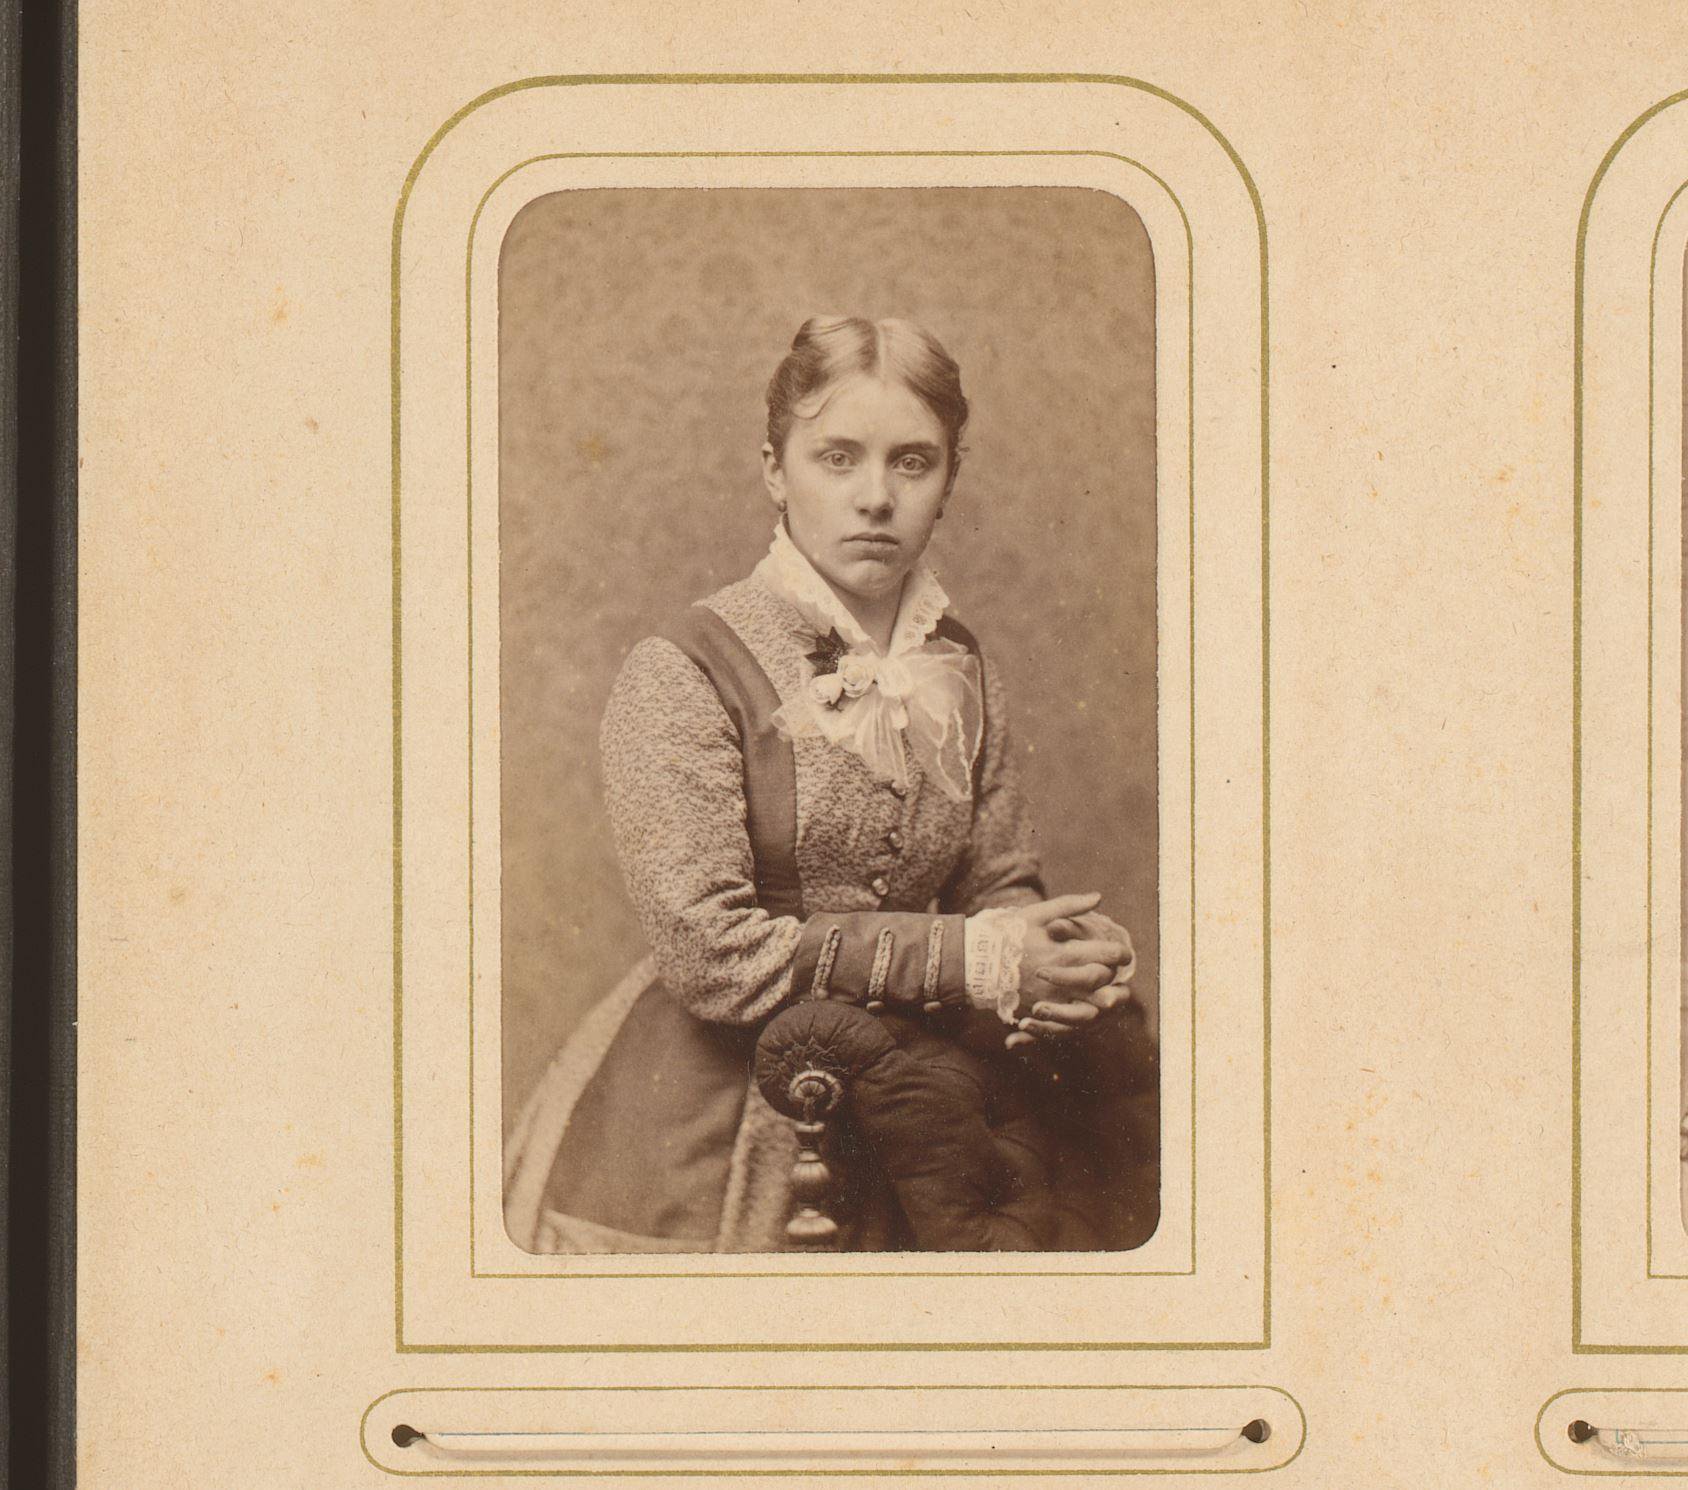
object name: carte de visite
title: Portret van een staande vrouw, leunend op de leuning van een fauteuil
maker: johannes gerardus kramer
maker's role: fotograaf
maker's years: 1845-1903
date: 1878-1903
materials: cardboard, photographic support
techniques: albumen print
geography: groningen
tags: historical persons - bb - woman, standing figure - aa - female human figure, chair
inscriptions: inscription: ‘Bekroond met Zilver/ UTRECHT/ 1876./ VEENDAM/ 1878./ J. G. Kramer/ PHOTOGRAPHISCH ATELIER/ A KERK, H 129./ GRONINGEN./ No. .../ Het negativ blijft ter nabestelling bewaard./ Vergrootingen in alle afmetingen.’